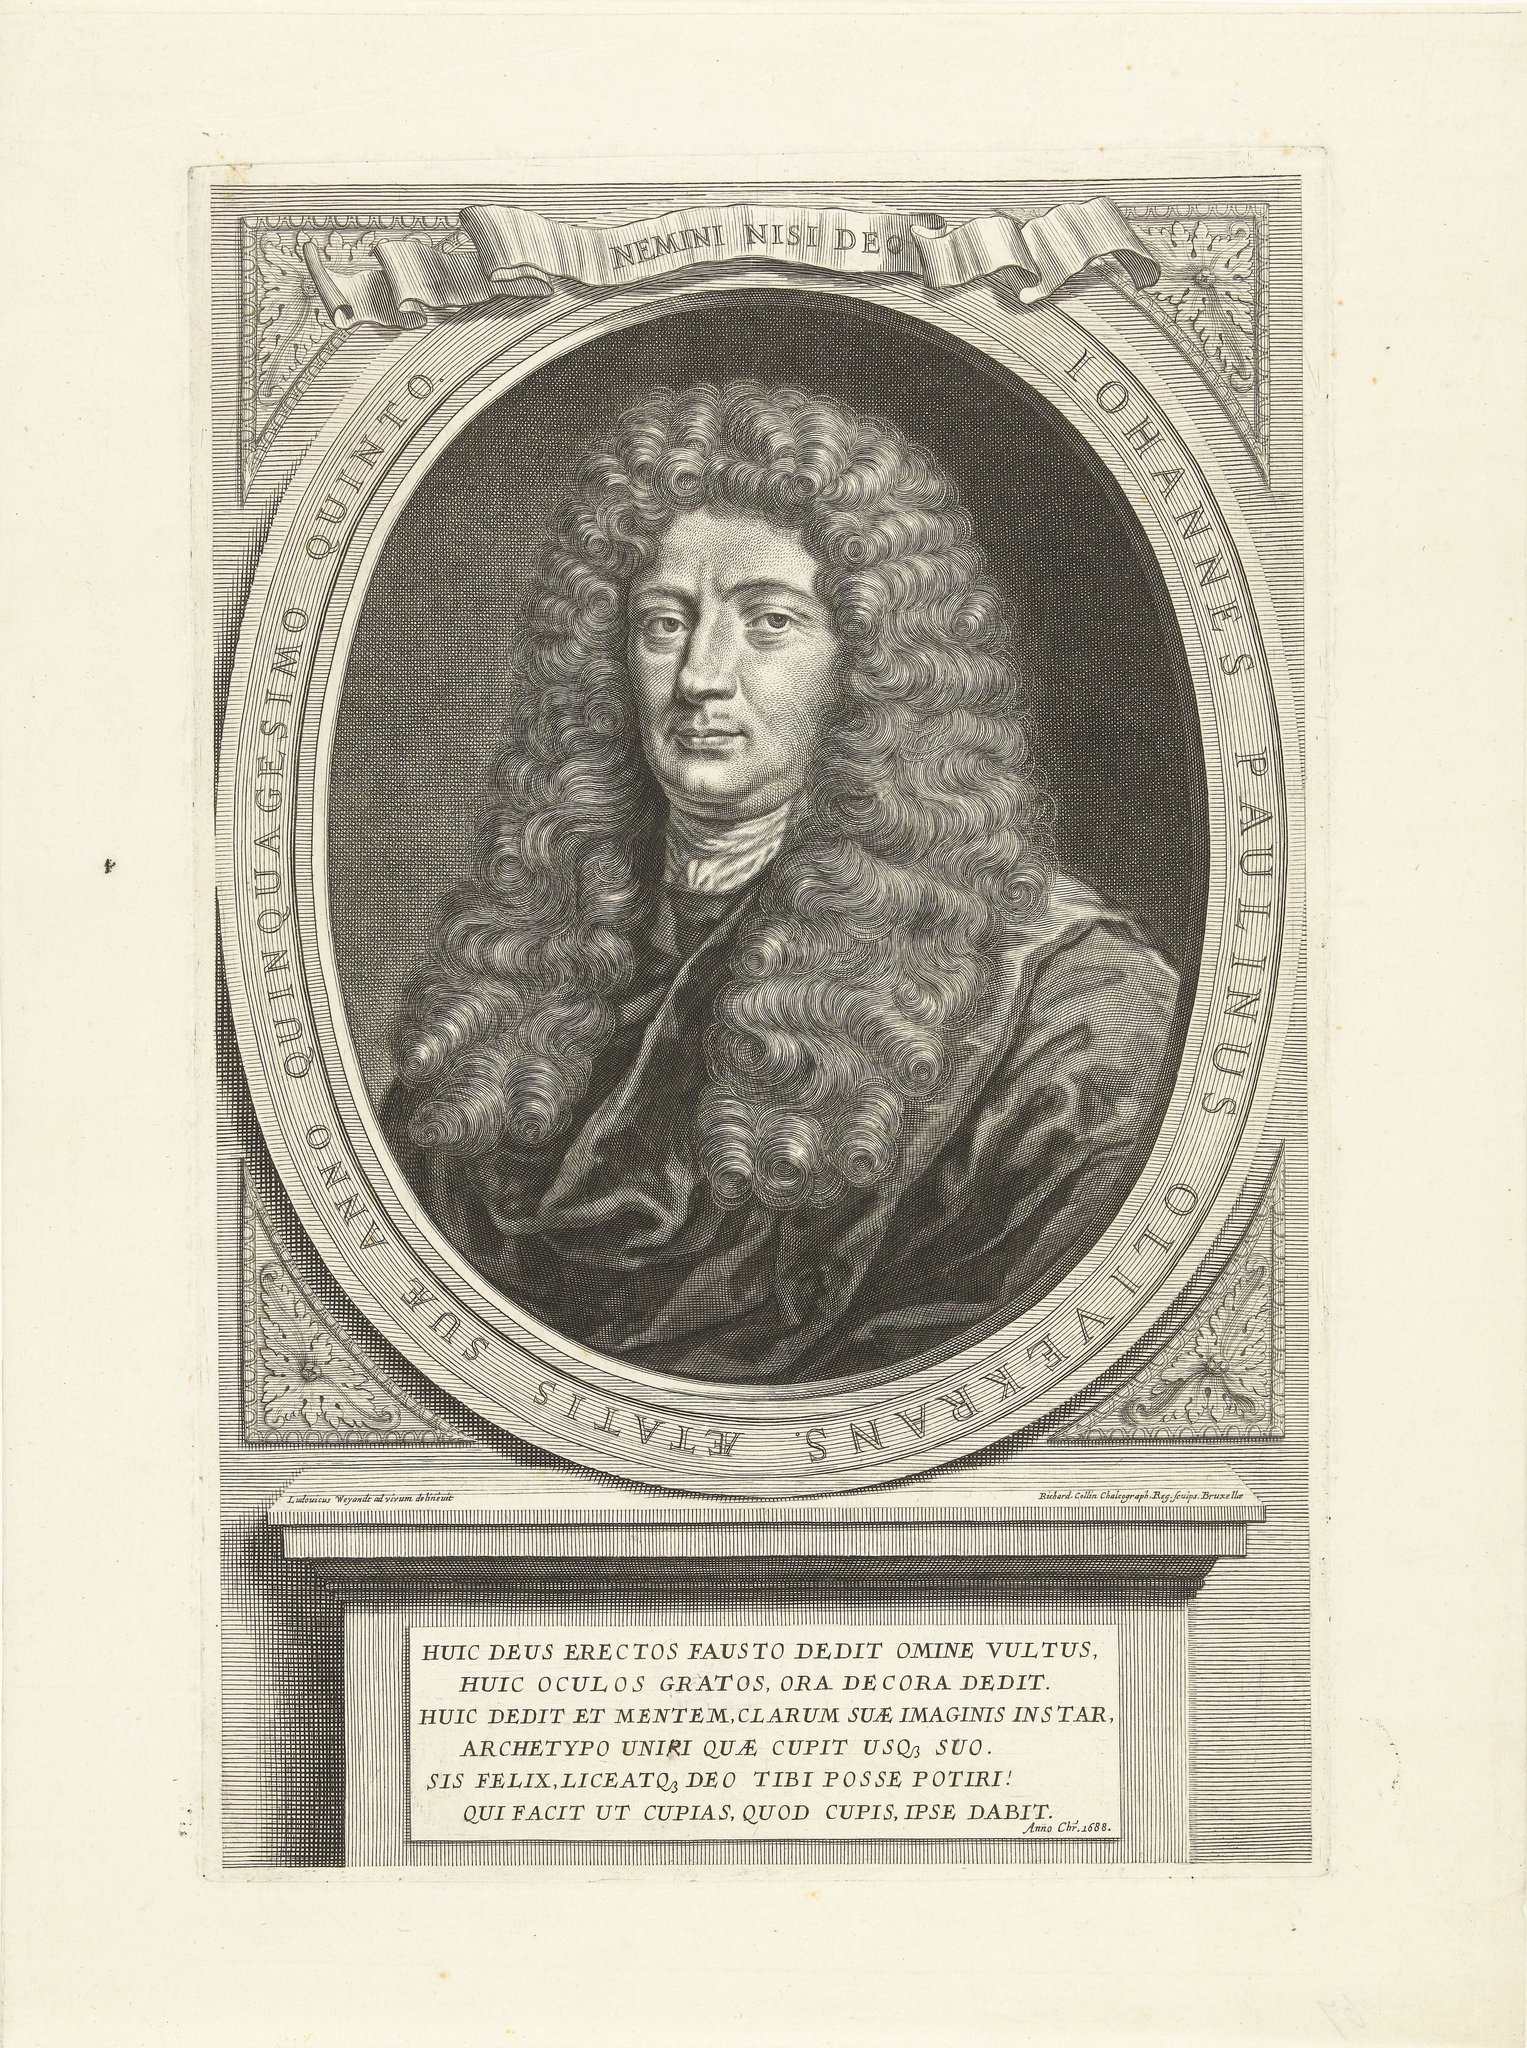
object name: print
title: Portret van Johannes Paulinus Olivecrants op 55-jarige leeftijd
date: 1688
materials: paper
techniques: engraving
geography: brussels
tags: gouverneur, diplomaat, johan paulinus olivecrantz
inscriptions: collector's mark: Lugt 2228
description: Borstbeeld van de Zweedse diplomaat Johannes Paulinus Olivecrants. In ovaal met randschrift. Op een piëdestal staat een tekst over Olivecrants in het Latijn.